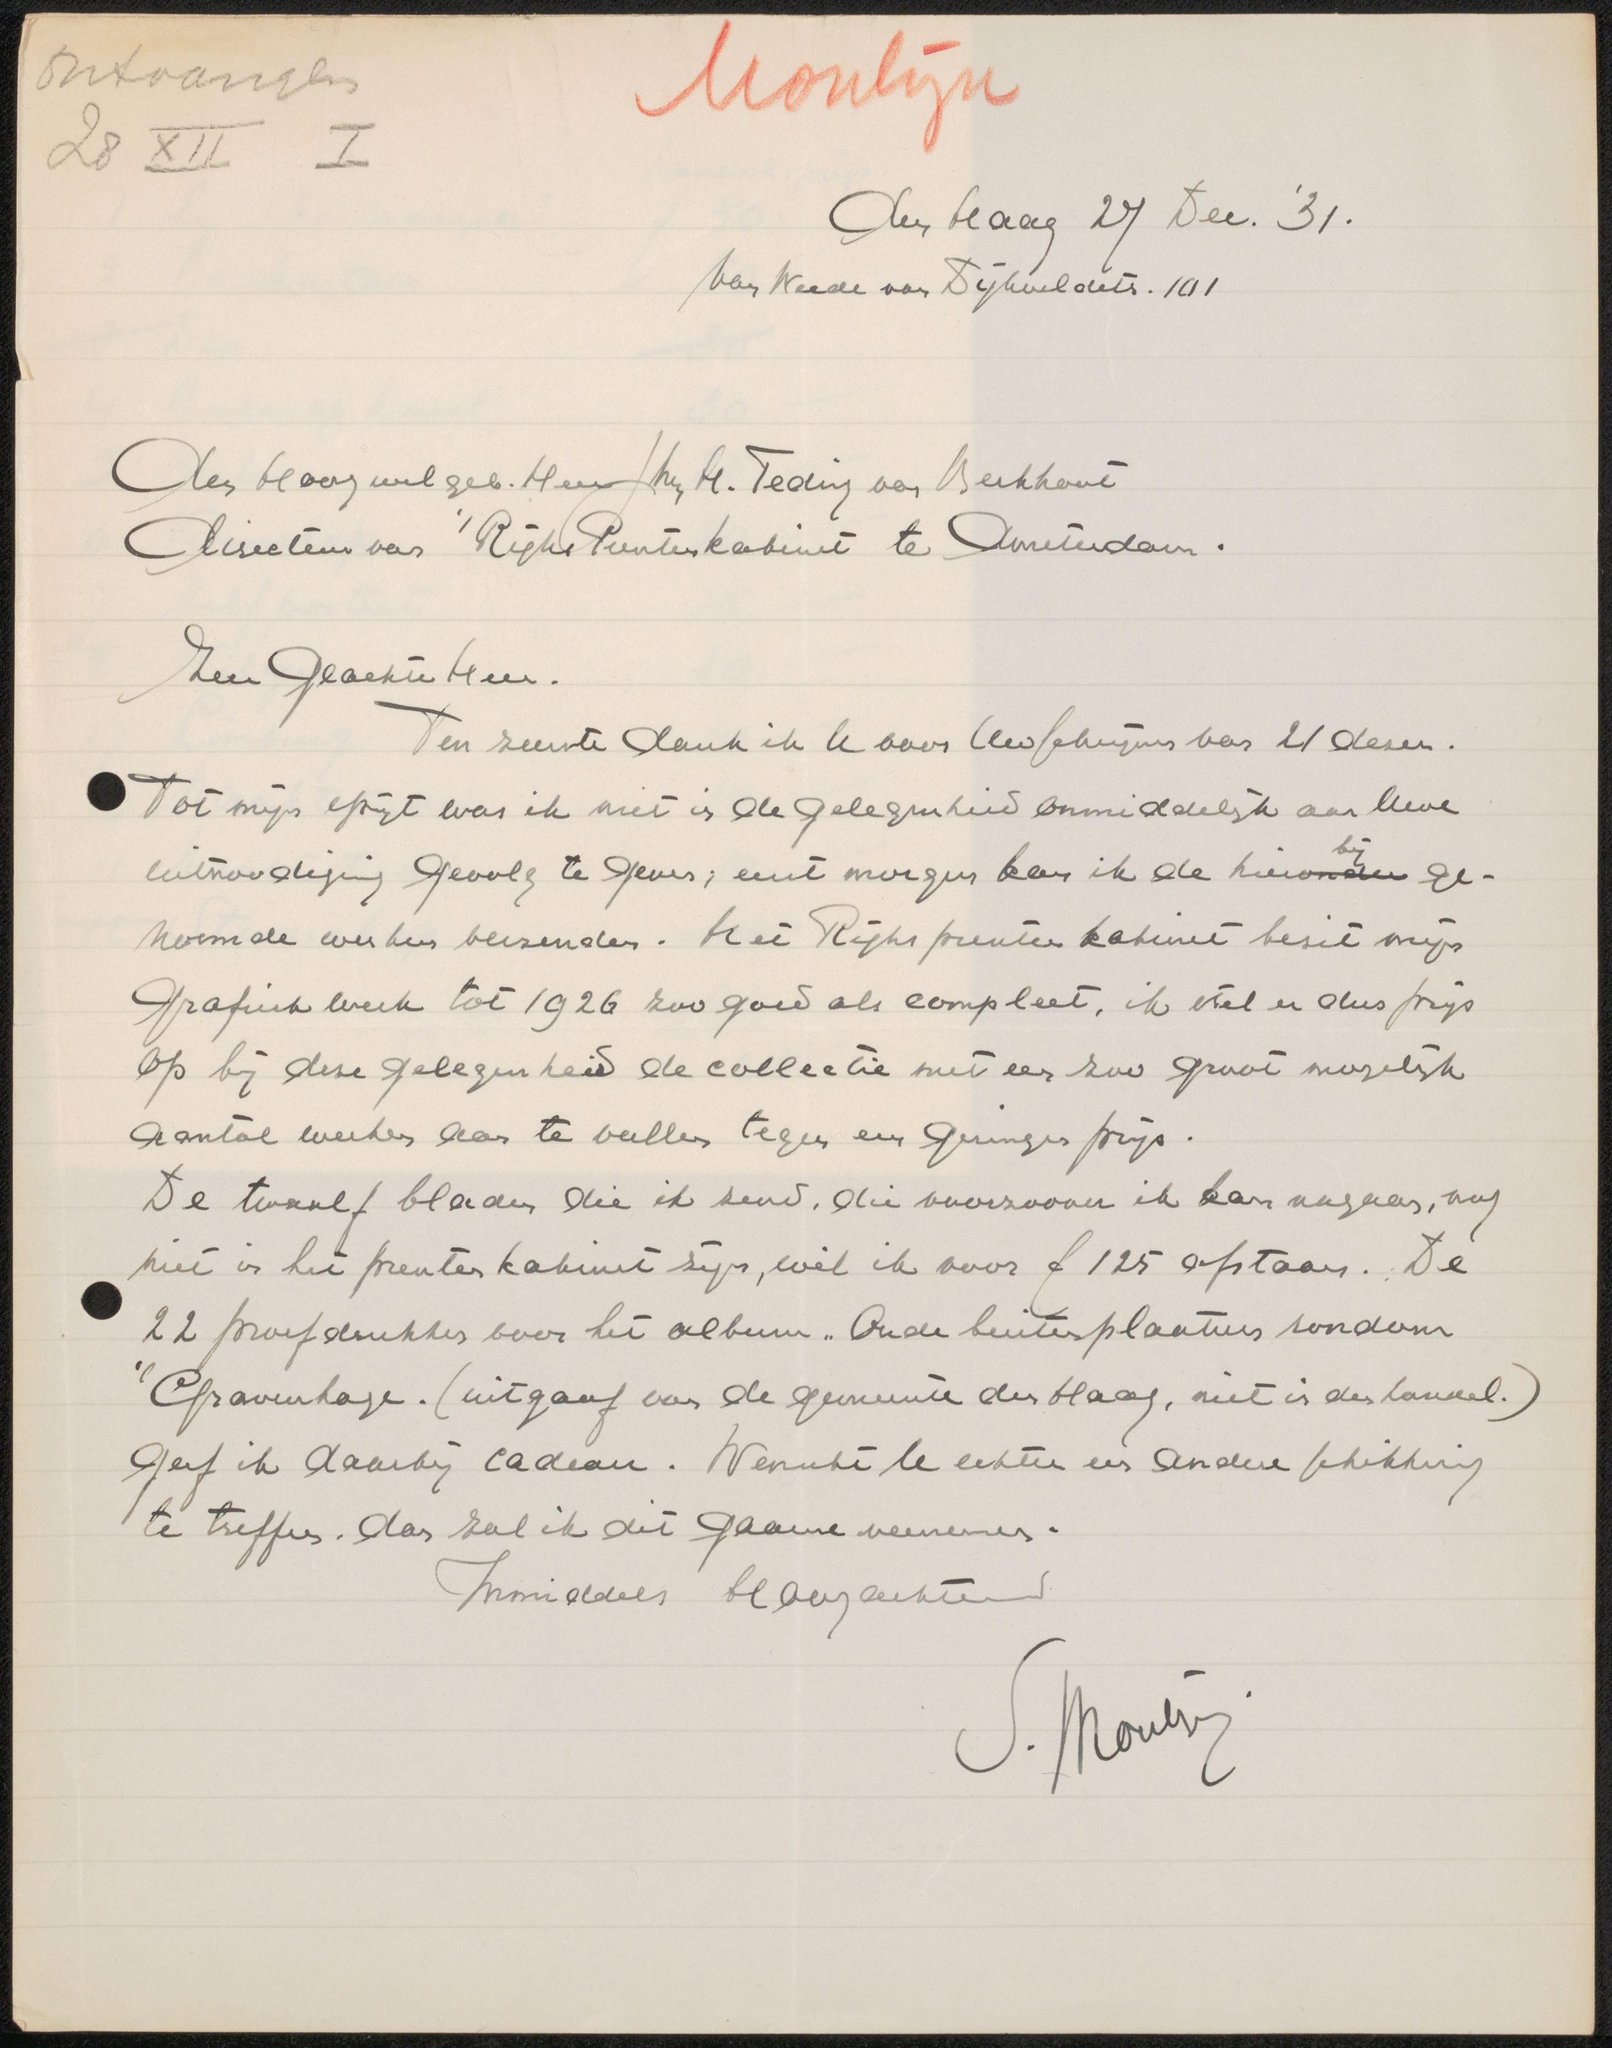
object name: letter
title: Brief aan jonkheer Hendrik Teding van Berkhout (1879-1969)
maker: simon moulijn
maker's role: draughtsman, print maker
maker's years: 1866-1948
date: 1931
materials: ink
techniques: pen, writing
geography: the hague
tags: print room, amsterdam, jonkheer hendrik teding van berkhout (1879-1969), the graphic arts, art collecting, money